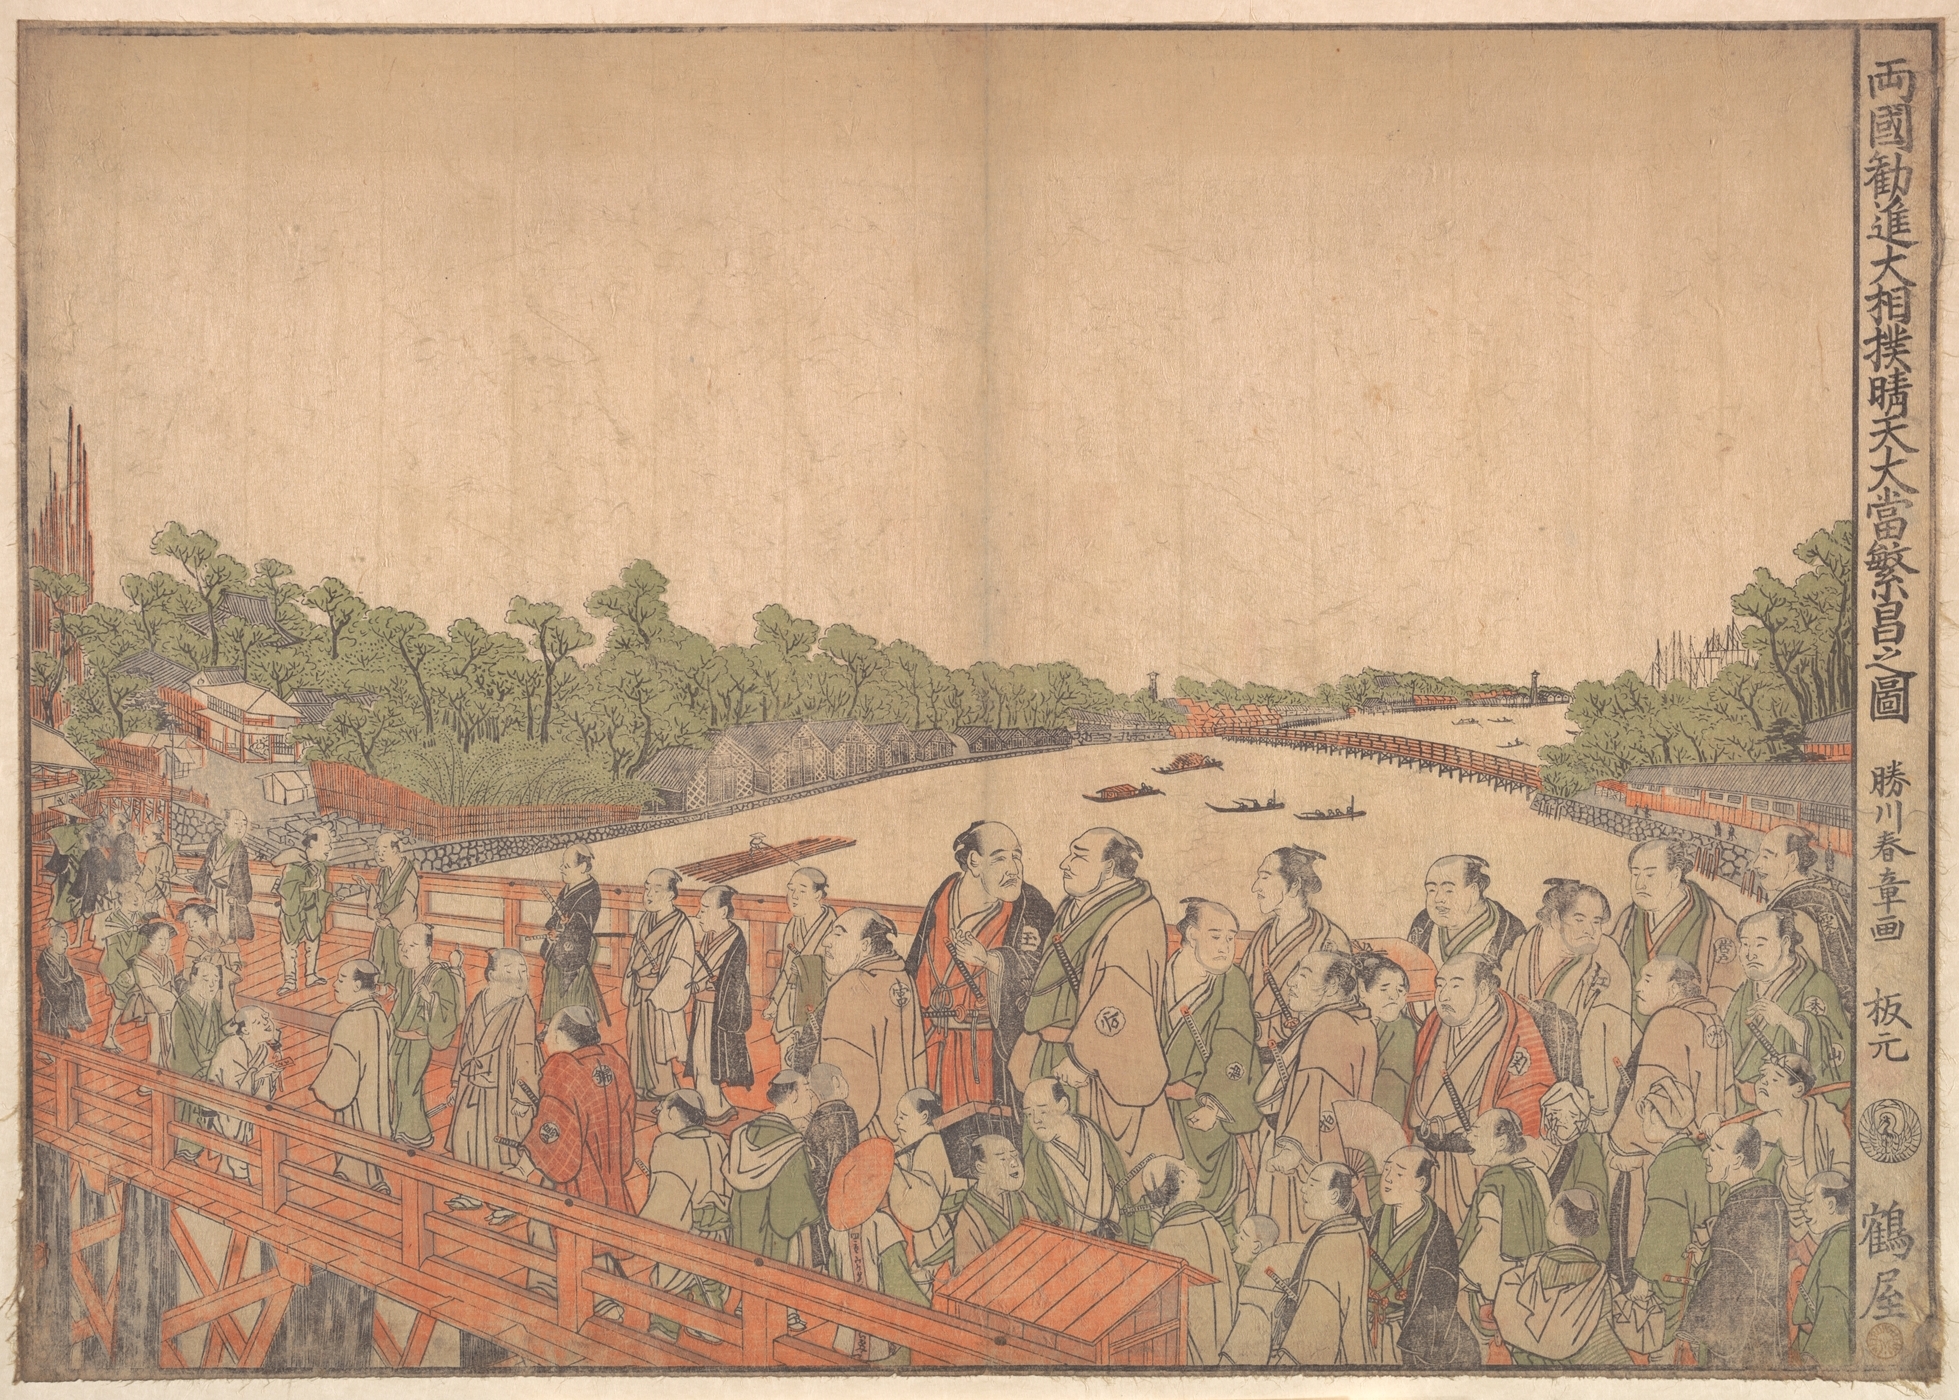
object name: woodblock print nishiki e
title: Ryogoku Kanjin Ōsumō sei-ten oatari hanjo no zu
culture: japanese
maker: katsukawa shunshō 勝川春章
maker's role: artist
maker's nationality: japanese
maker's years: 1726-1792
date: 1778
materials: ink, paper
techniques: nishiki e, woodblock print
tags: bridges,rivers,trees,crowd,boats